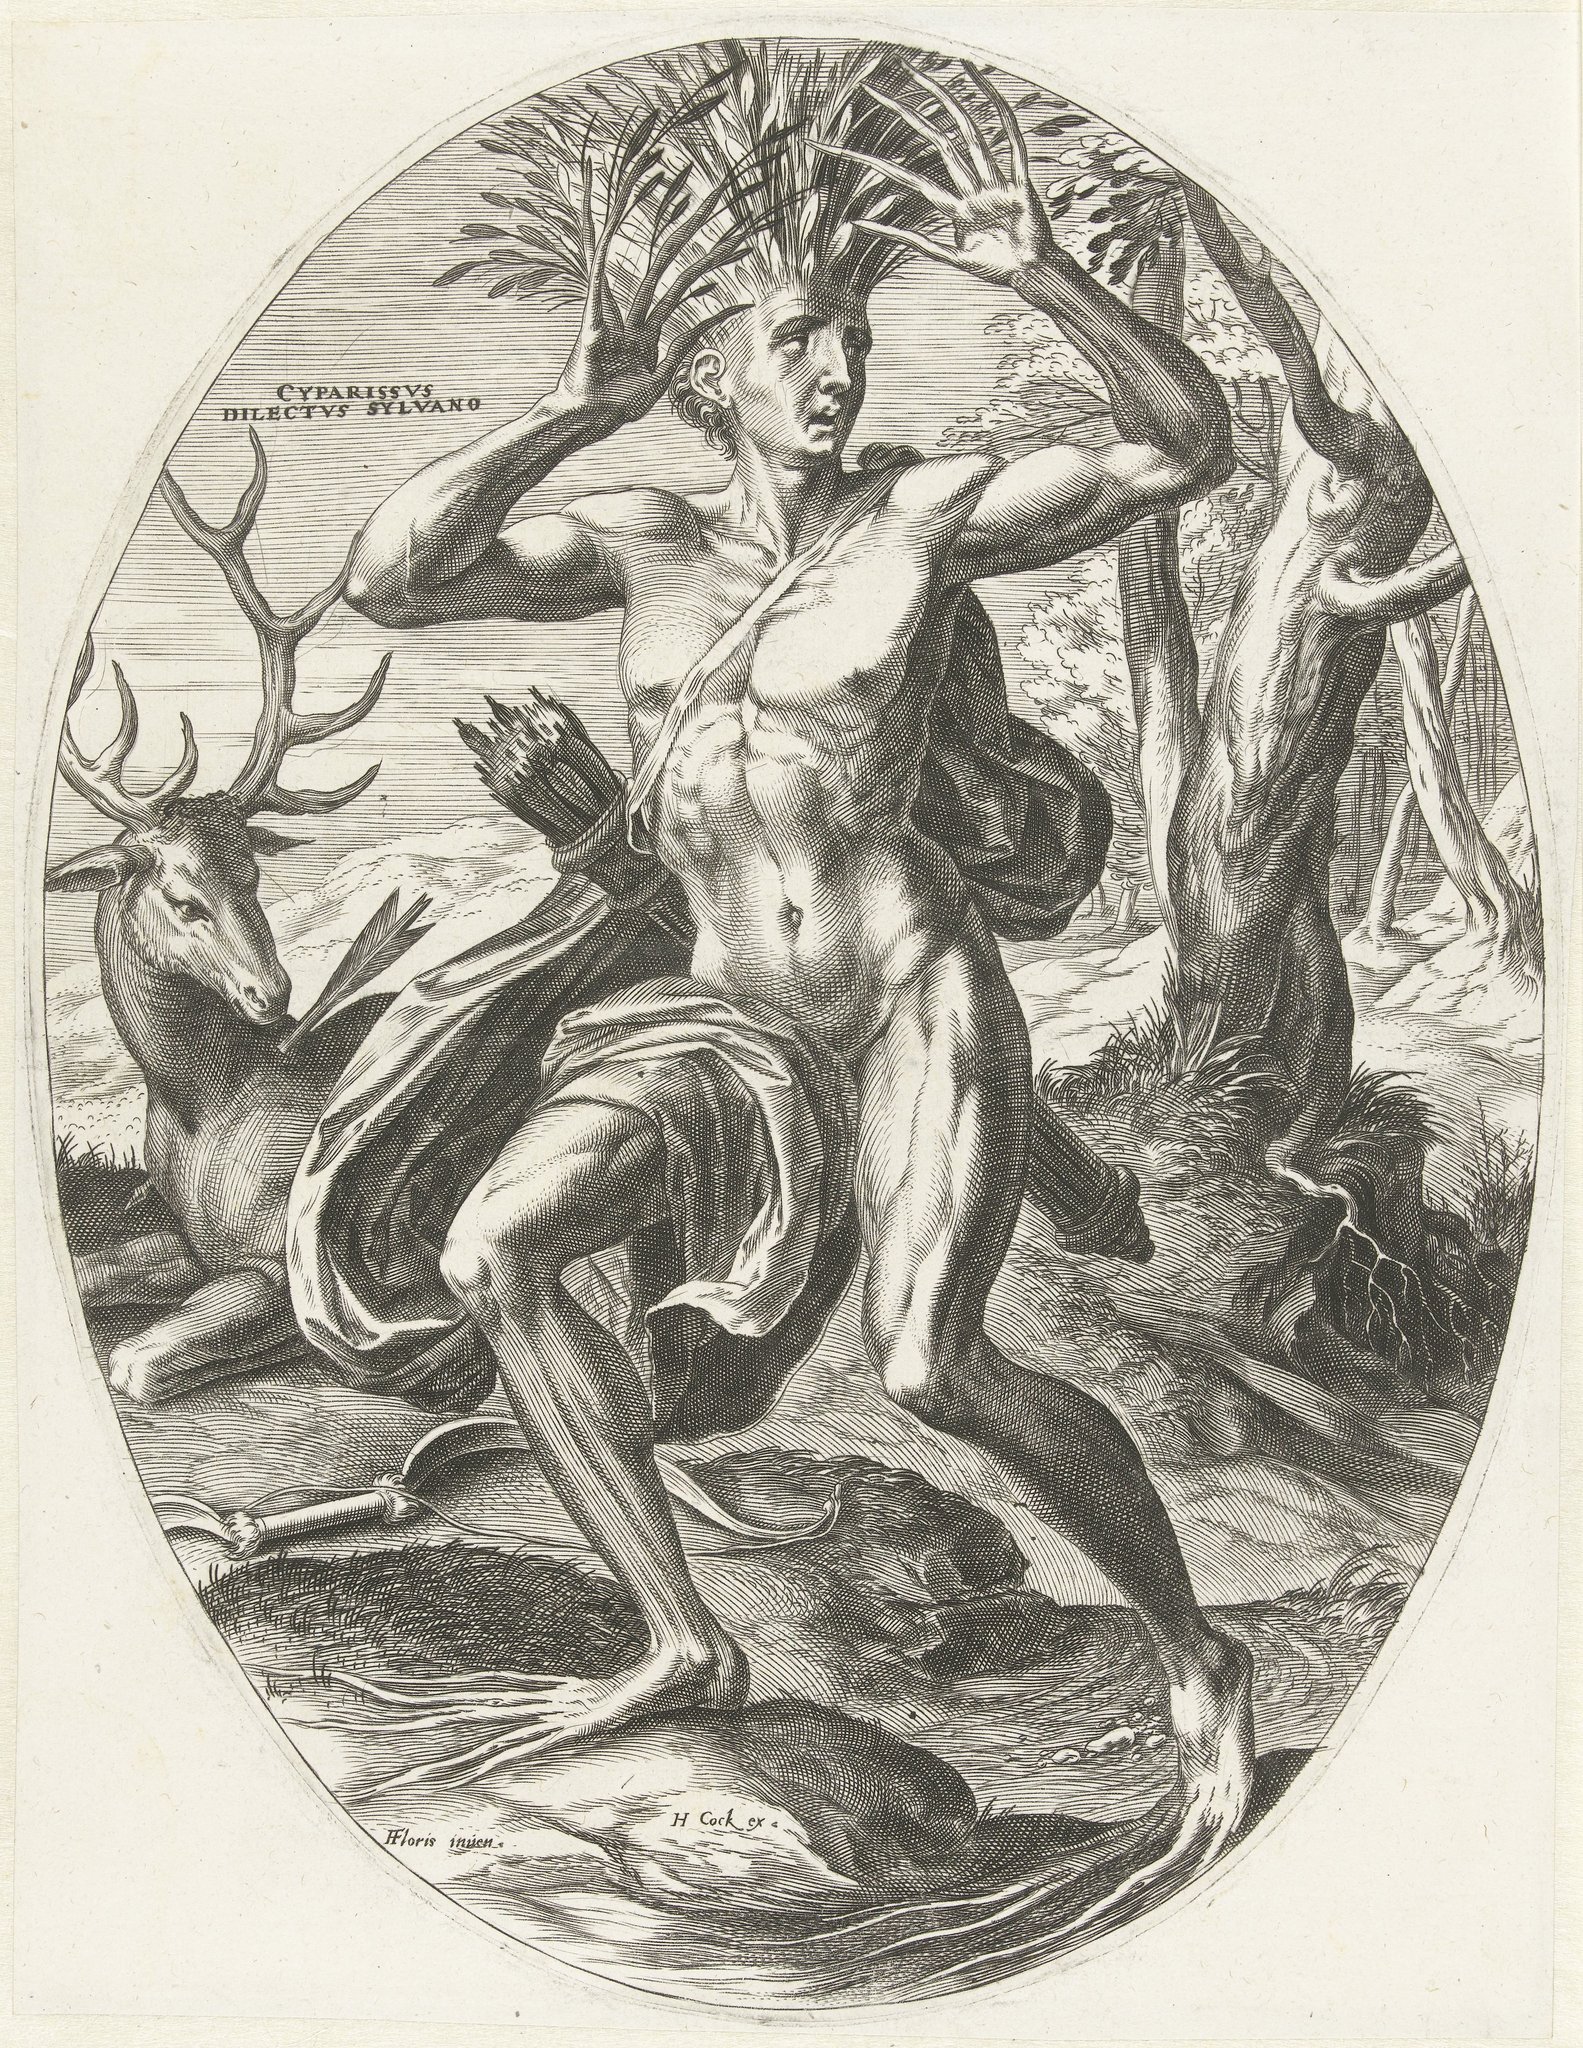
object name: print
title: Cyparissus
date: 1565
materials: paper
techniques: engraving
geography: antwerp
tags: cyparissus changed into a cypress: when pining away for the loss of his favourite stag, cyparissus the hunter, minion of apollo, is changed into a cypress by the god (ovid, metamorphoses x 106)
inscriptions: collector's mark: Lugt 2228, collector's mark: Lugt 1379, collector's mark: Lugt 2542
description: Cyparissus wordt door Apollo in een cipres verandert omdat hij treurt om de dood van zijn favoriete hert. Het hert dat door een pijl getroffen is ligt achter Cyparissus. Uit Cyparissus handen en haren groeien takken met bladeren. Uit zijn tenen groeien wortels.